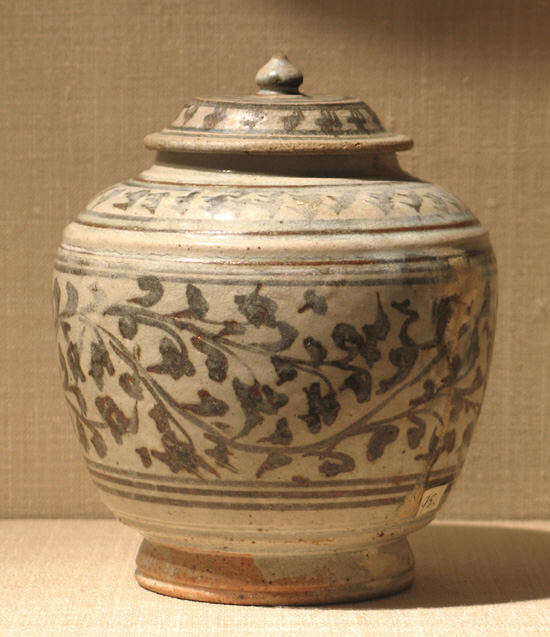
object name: covered jar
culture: thai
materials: earthenware, glaze, iron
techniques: underglaze